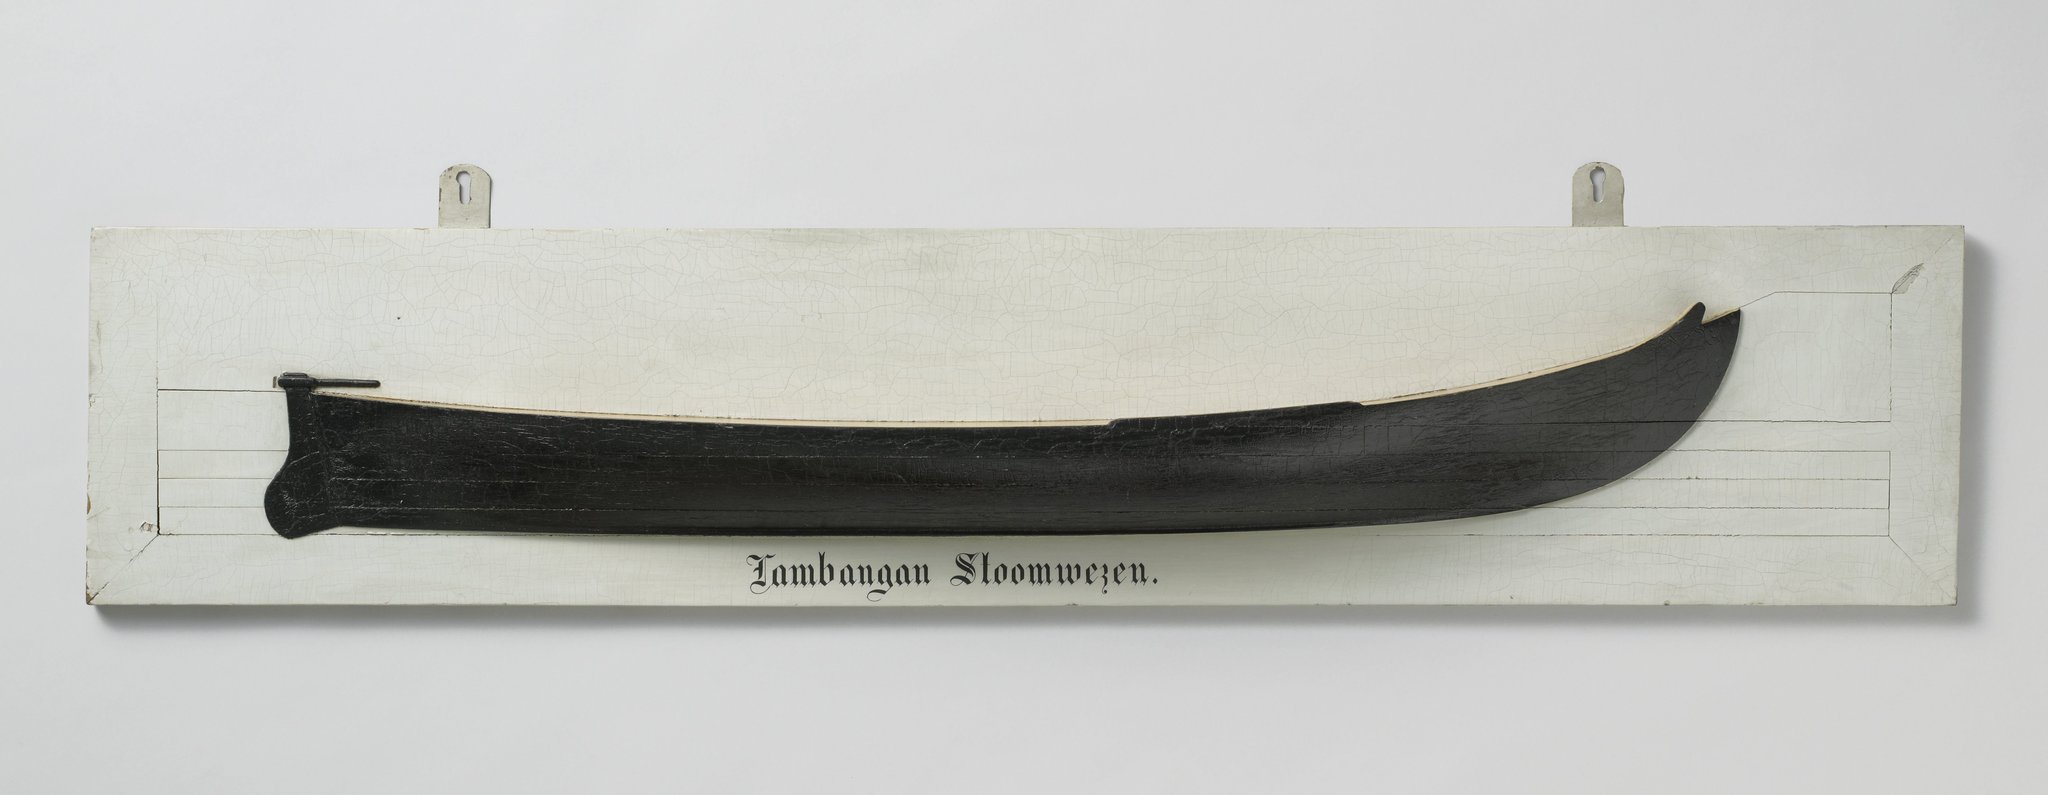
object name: ship model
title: Half Model of a Tambangan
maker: Anonymous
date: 1860-1880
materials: wood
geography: indonesian archipelago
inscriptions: inscription, bottom centre, in a Gothic hand: ‘Tambangan Stoomwezen.’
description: Een tambangan is een klein roeivaartuigje bestemd voor het vervoeren van passagiers. Deze tambangan werd blijkens het opschrift voor de Dienst Stoomwezen in Oost-Indië gebouwd. Er is geen verdere informatie over het model bekend.